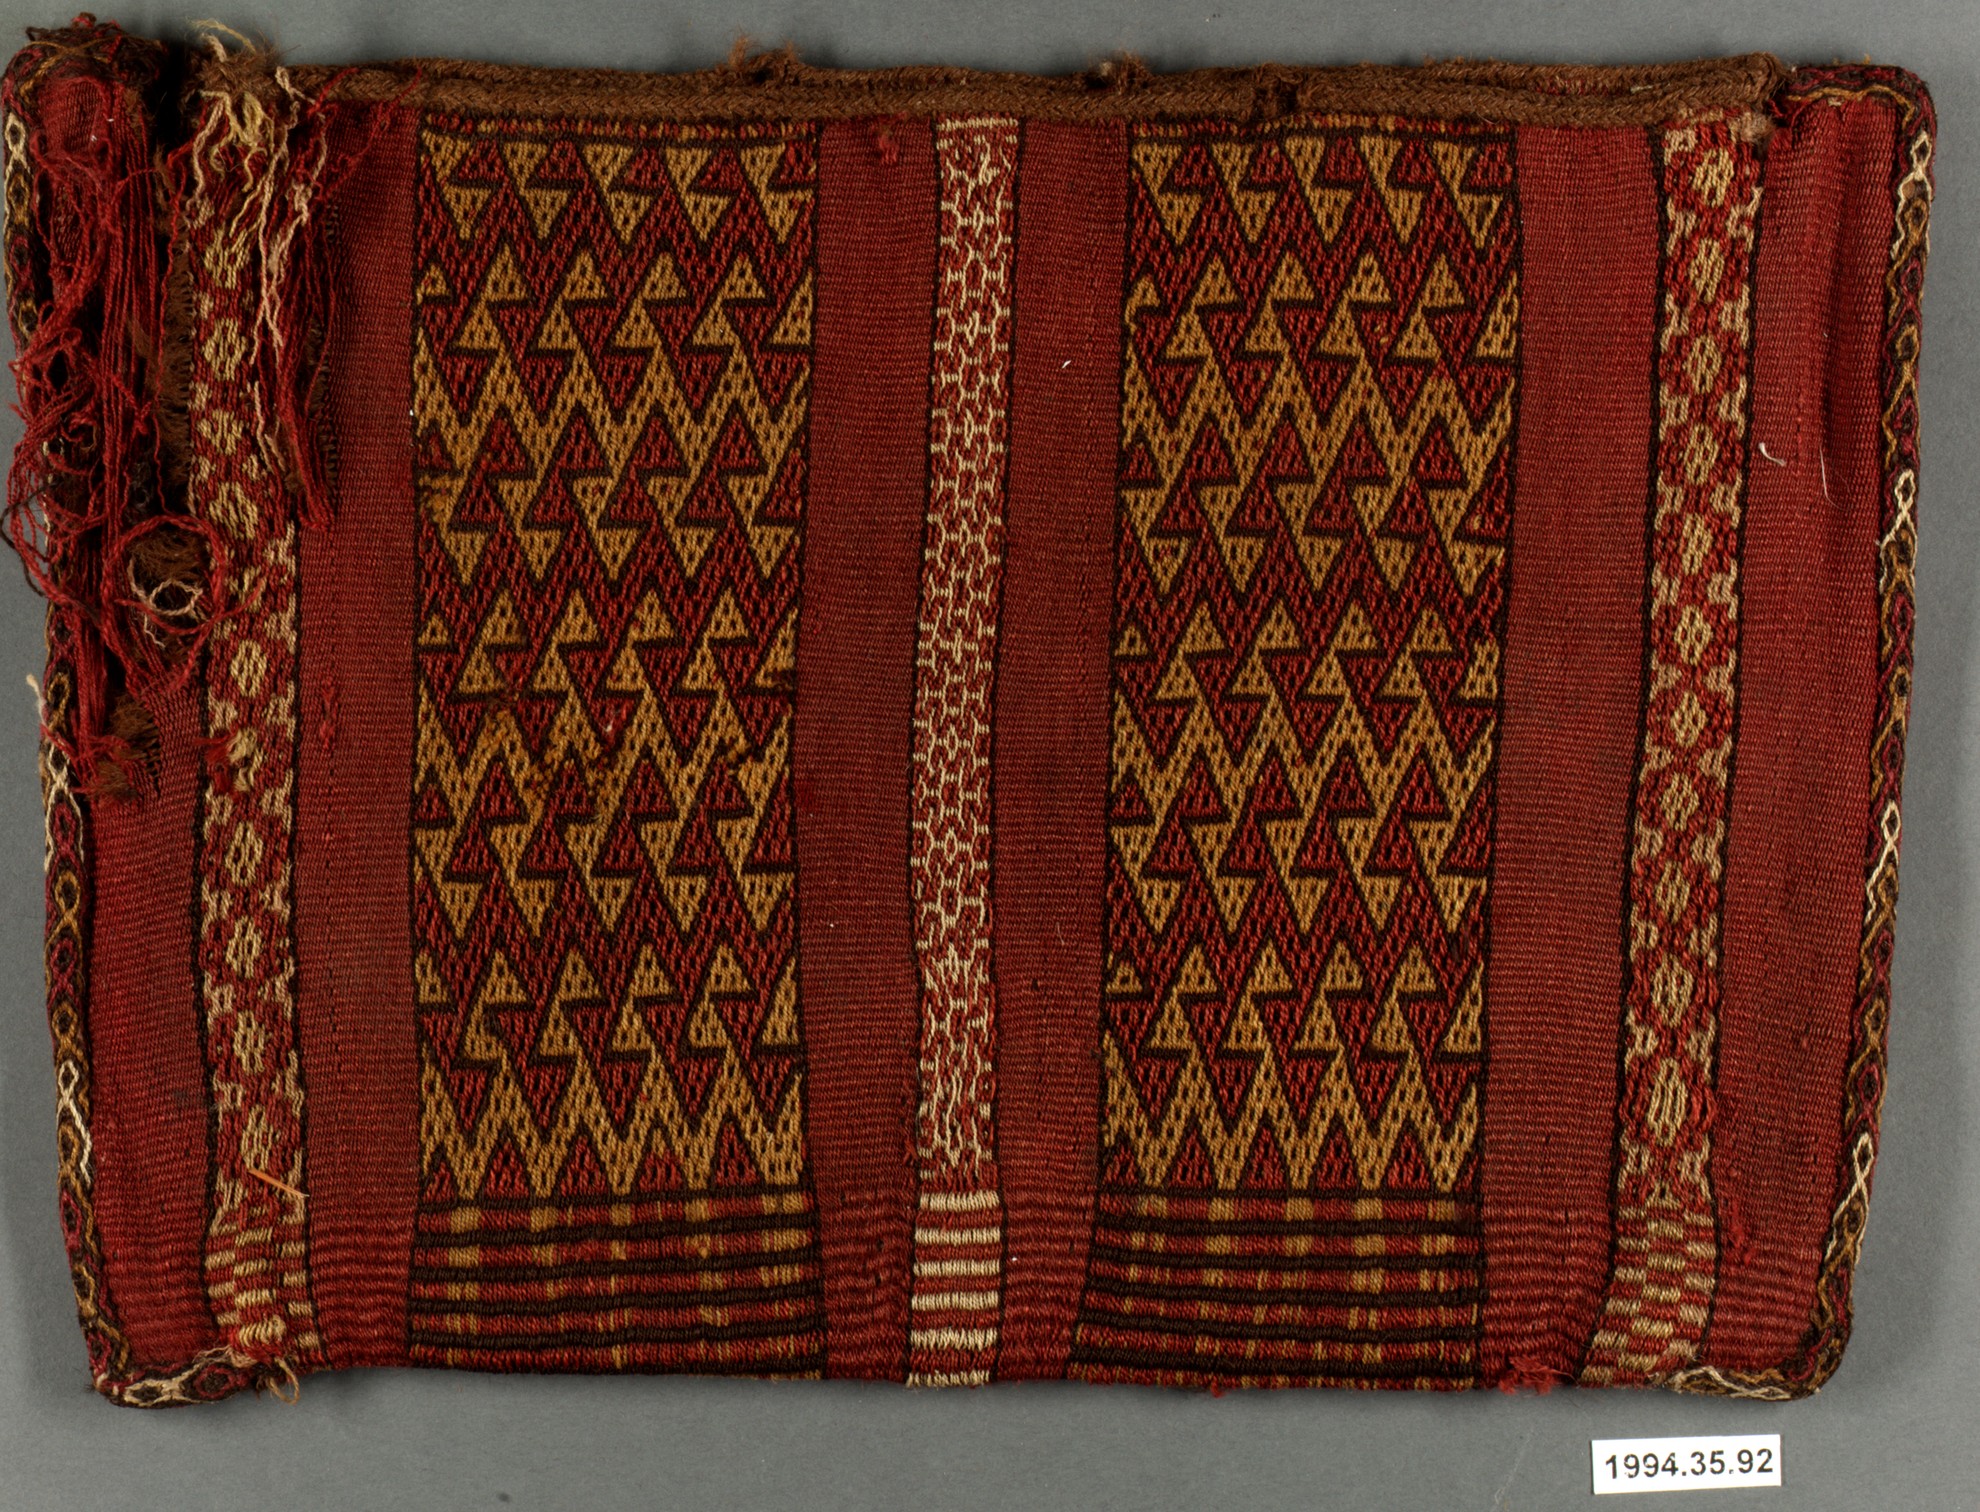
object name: bag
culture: peruvian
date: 1301-1533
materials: animal fiber, cotton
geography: peru